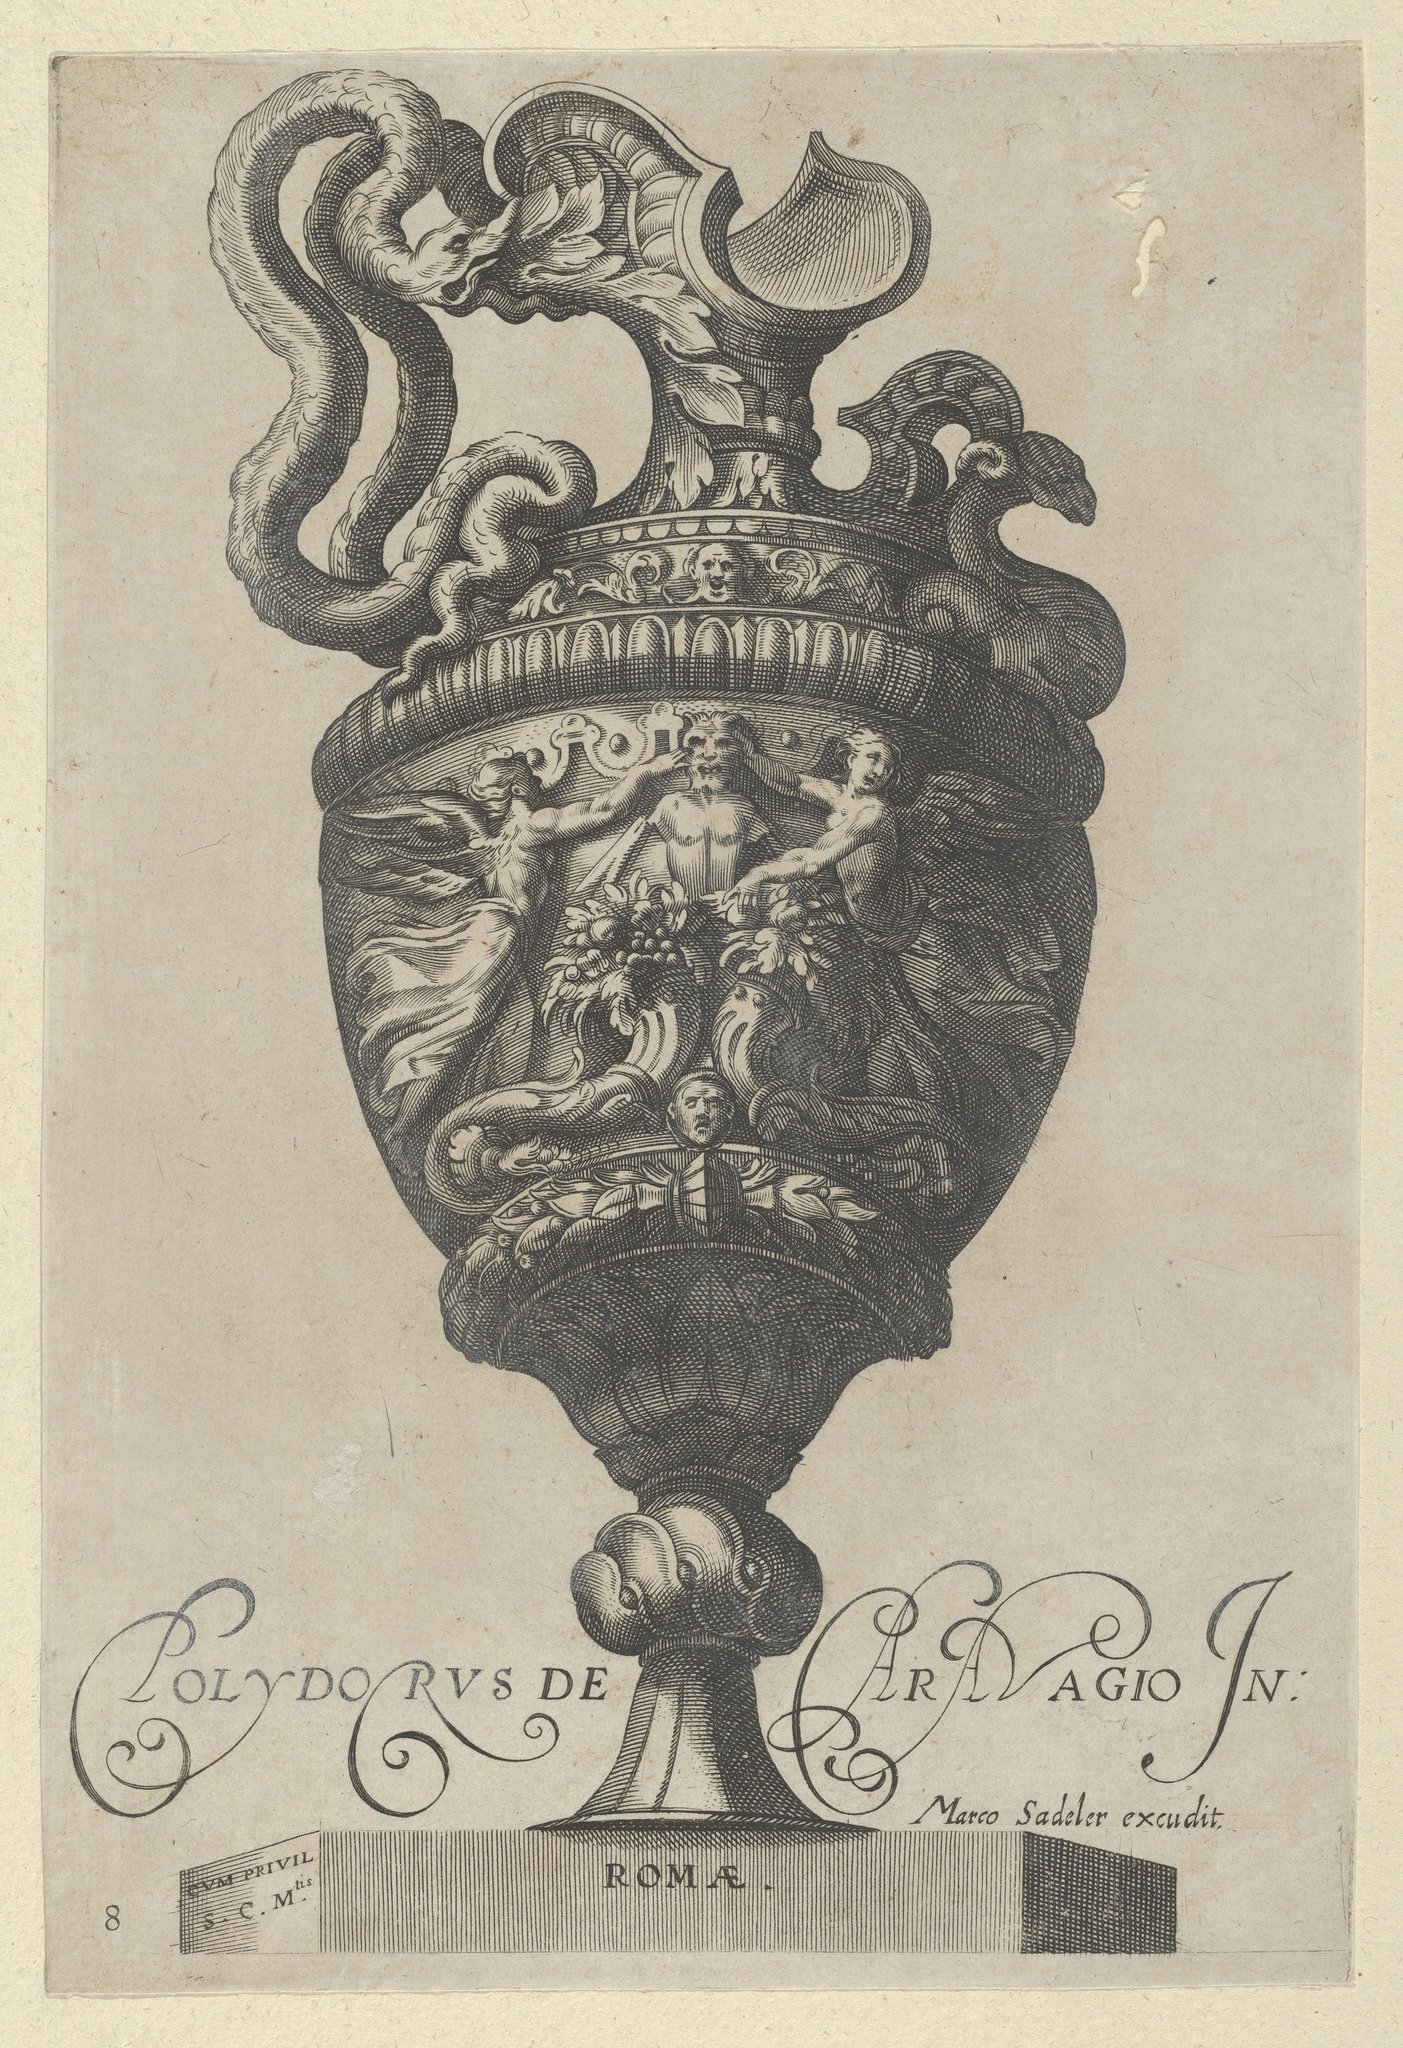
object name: print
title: Plate 8: Vase or Ewer Decorated with a Satyr Figure, Behind Two Cornucopias, and Two Winged Victory Figures, from "Antique Vases" (Vasa a Polydoro Caravagino)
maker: aegidius sadeler (ii)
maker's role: artist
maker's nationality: flemish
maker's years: 1568-1629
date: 1605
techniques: engraving, etching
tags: satyrs,cornucopia,ewers,vases